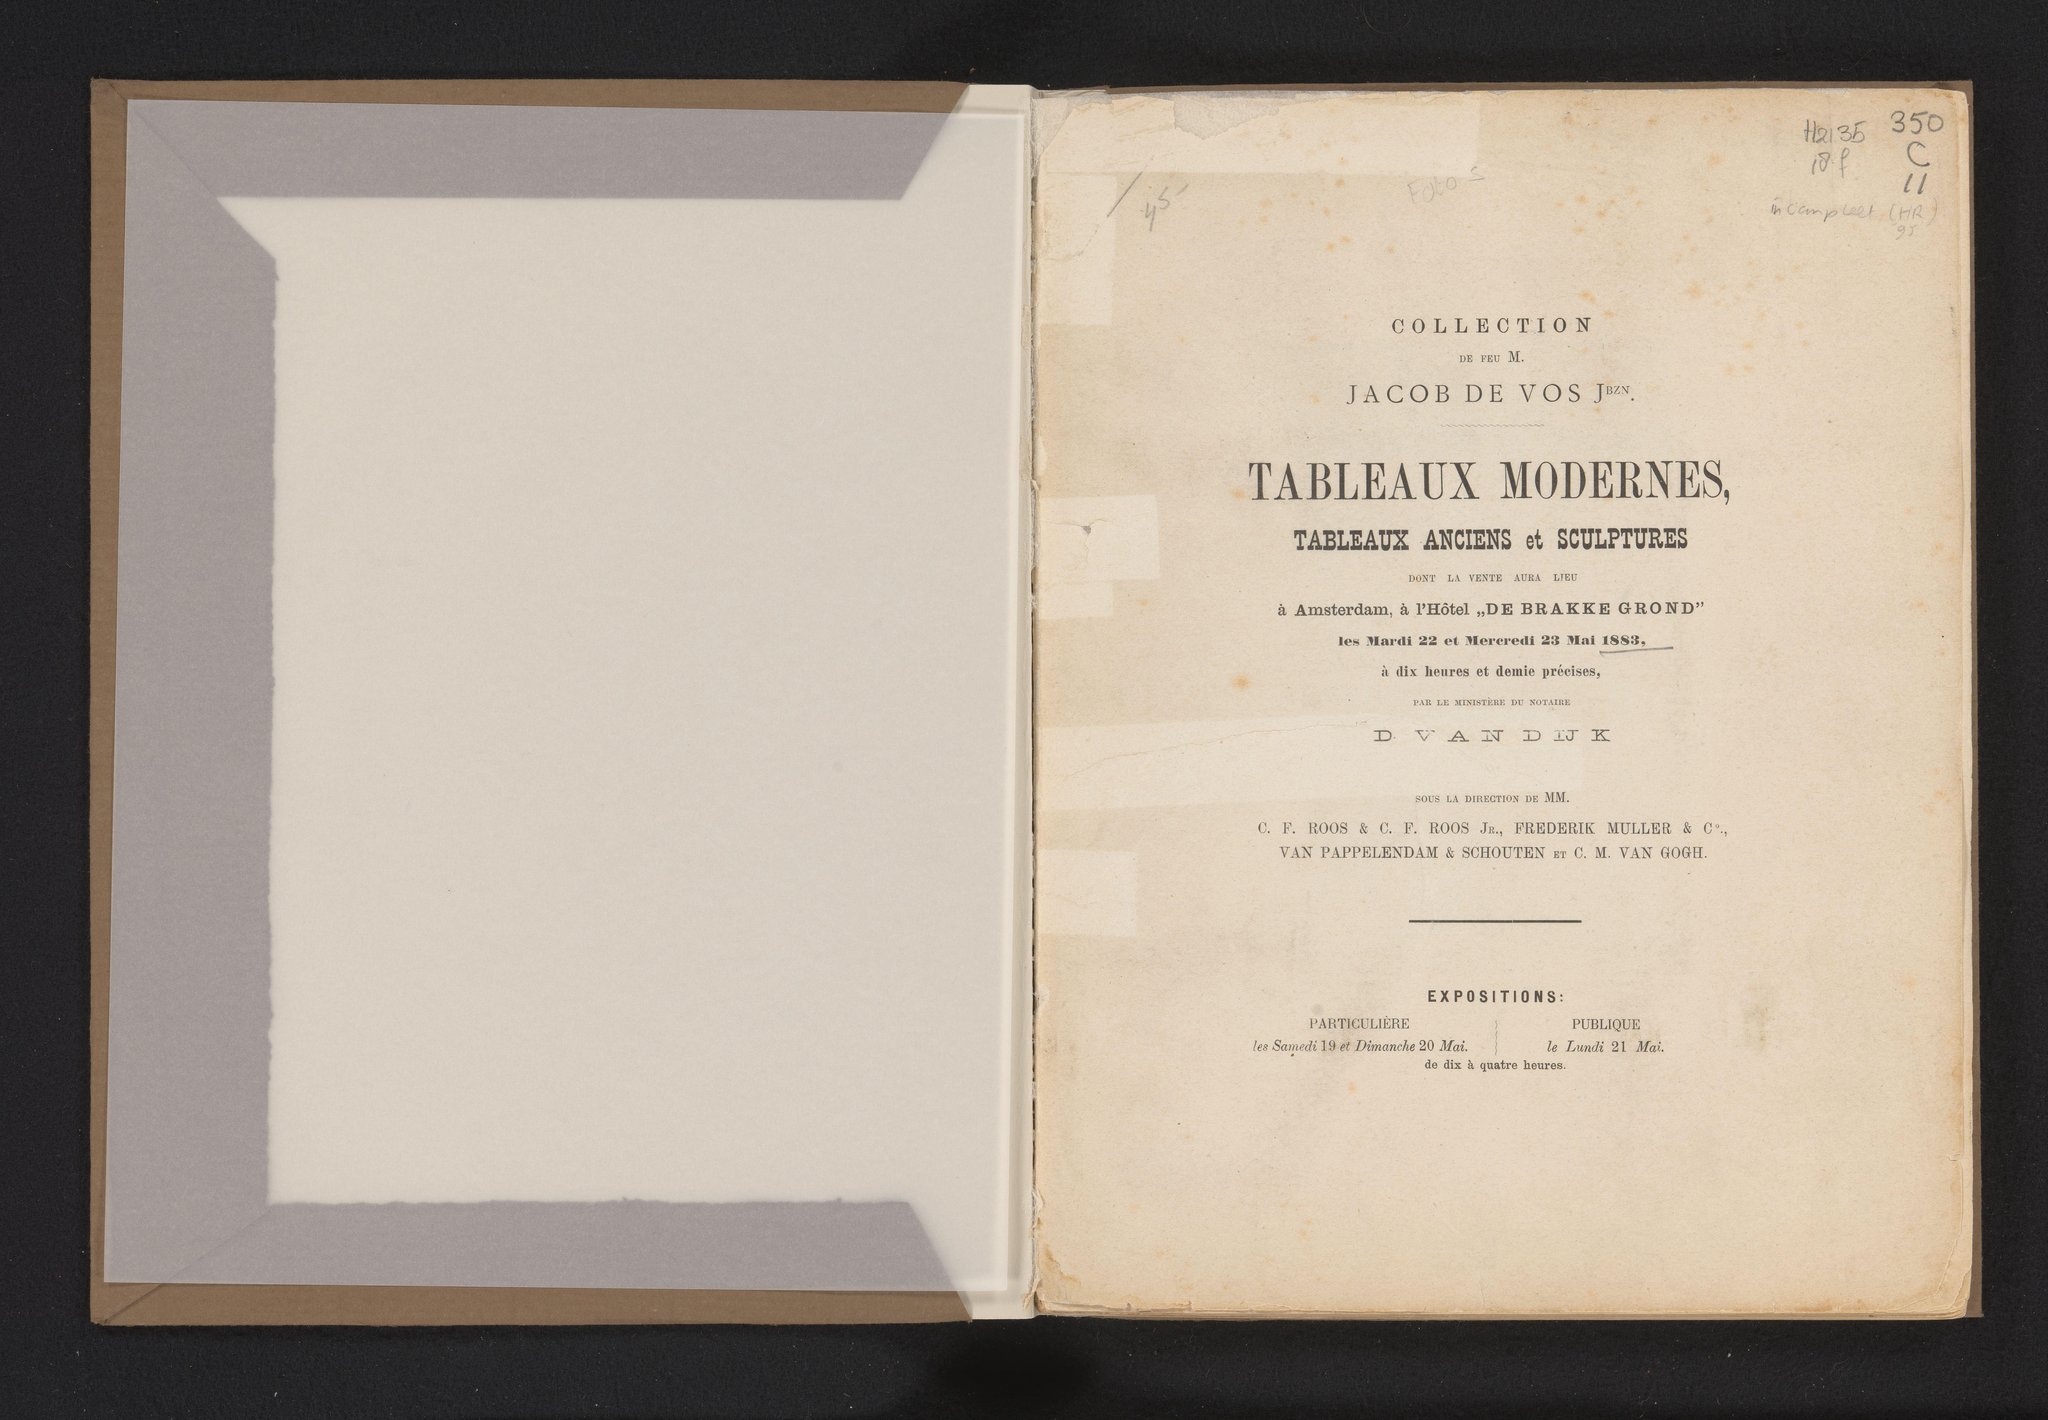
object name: book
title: Tableaux modernes, tableaux anciens et sculptures : collection de feu M. Jacob de Vos Jbzn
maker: Anonymous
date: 1883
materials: paper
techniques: albumen print, letterpress printing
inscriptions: inscription: ‘incompleet (HR)/ 95’, inscription: ‘45-’, inscription: ‘Foto's’